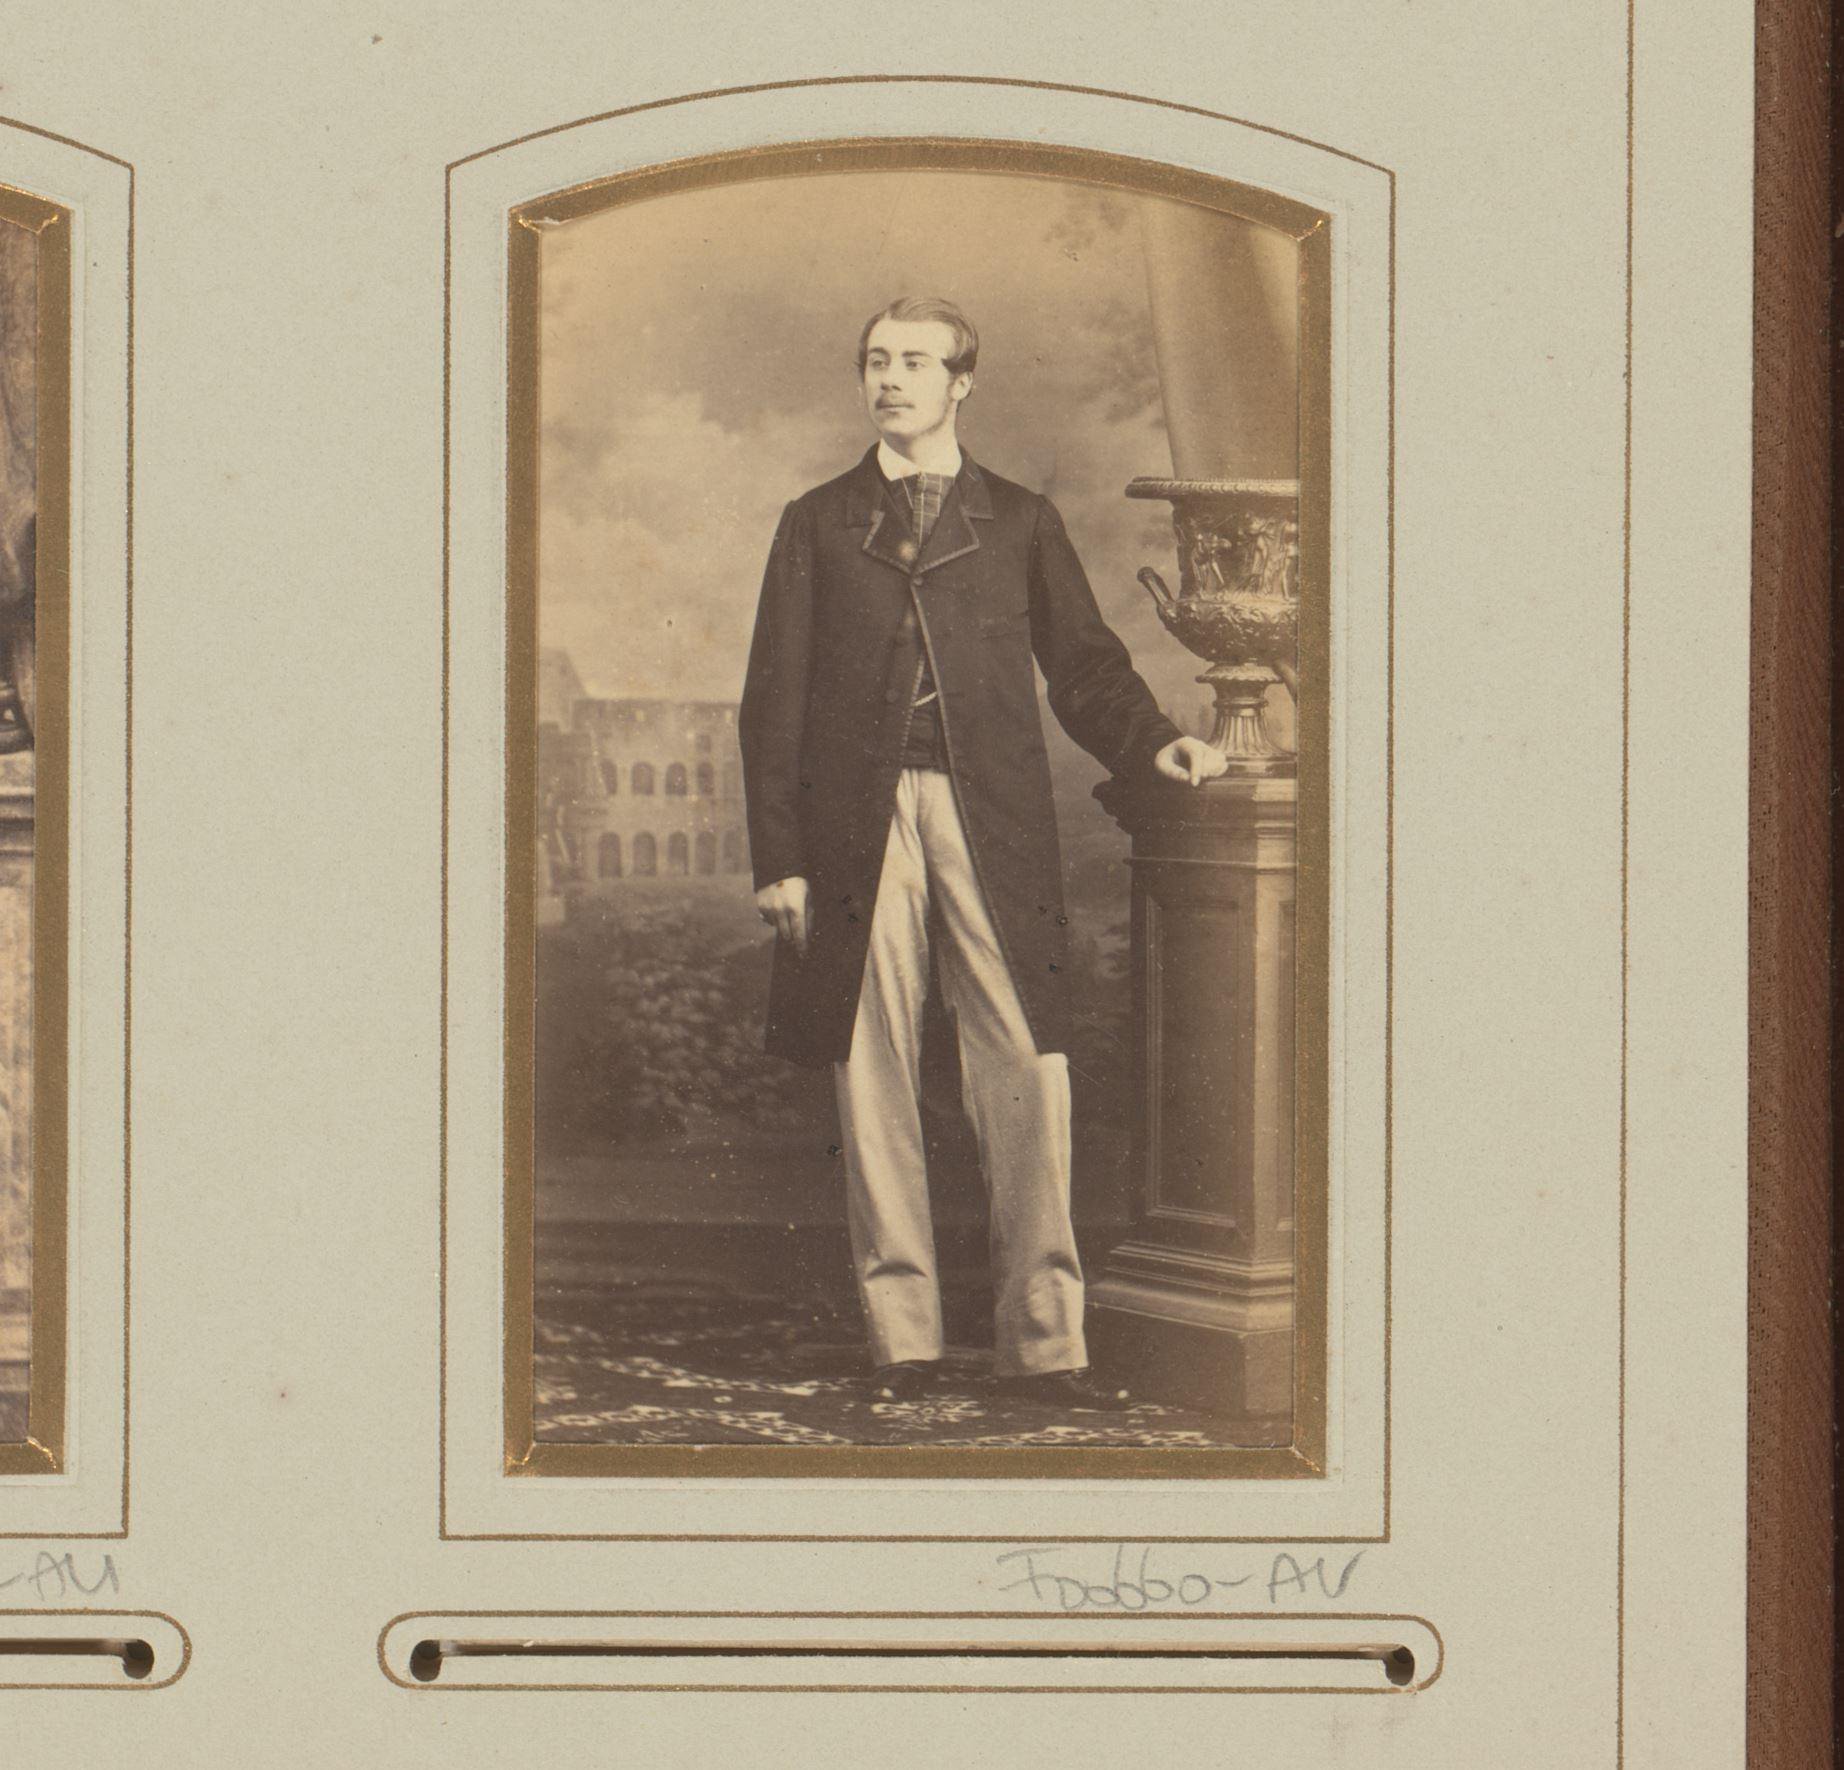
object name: carte de visite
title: Portret van een staande man bij een zuil met vaas, voor een achtergrond waarop het Colosseum is afgebeeld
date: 1870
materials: cardboard, photographic support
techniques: albumen print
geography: rome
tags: historical persons, pedestal of a piece of sculpture (perhaps in the form of a herm), container of metal: bucket, can, canister, drum, tin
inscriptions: inscription: ‘FRATELLI D'ACESSANDRI/ ROMA/ 65, Via del Babuino.’